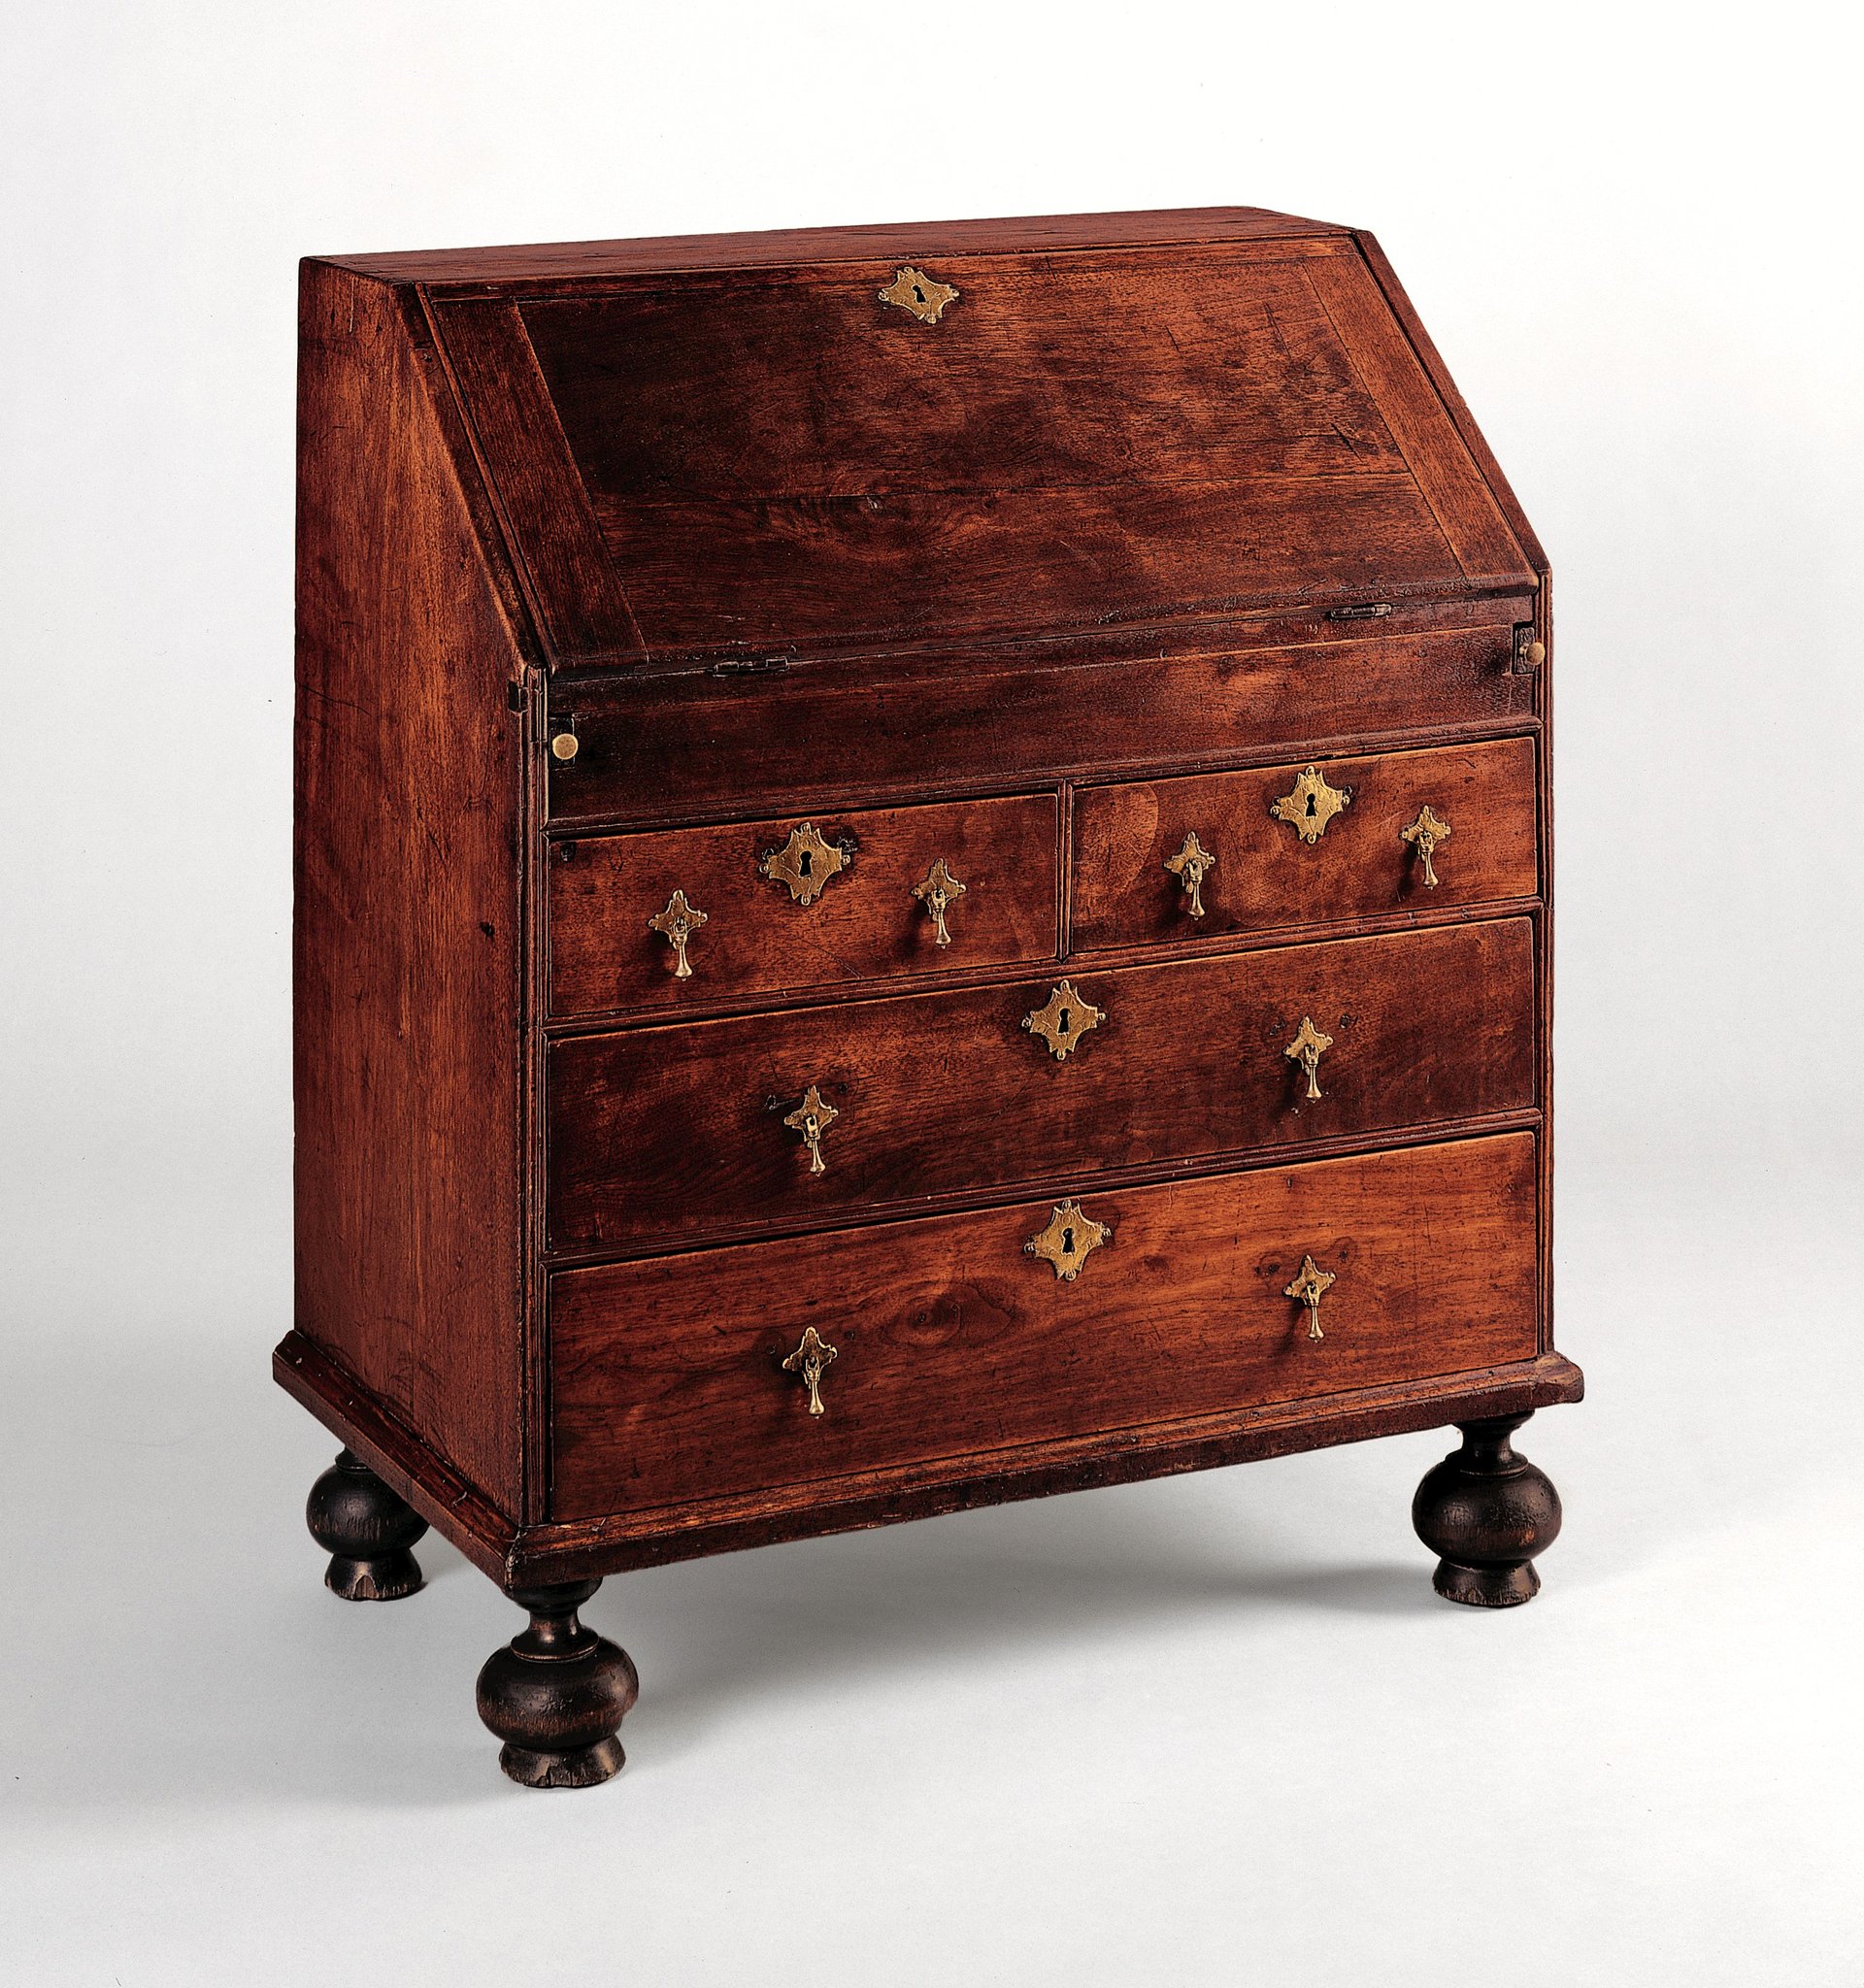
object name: desk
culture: american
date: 1710-1730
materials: wood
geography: united states